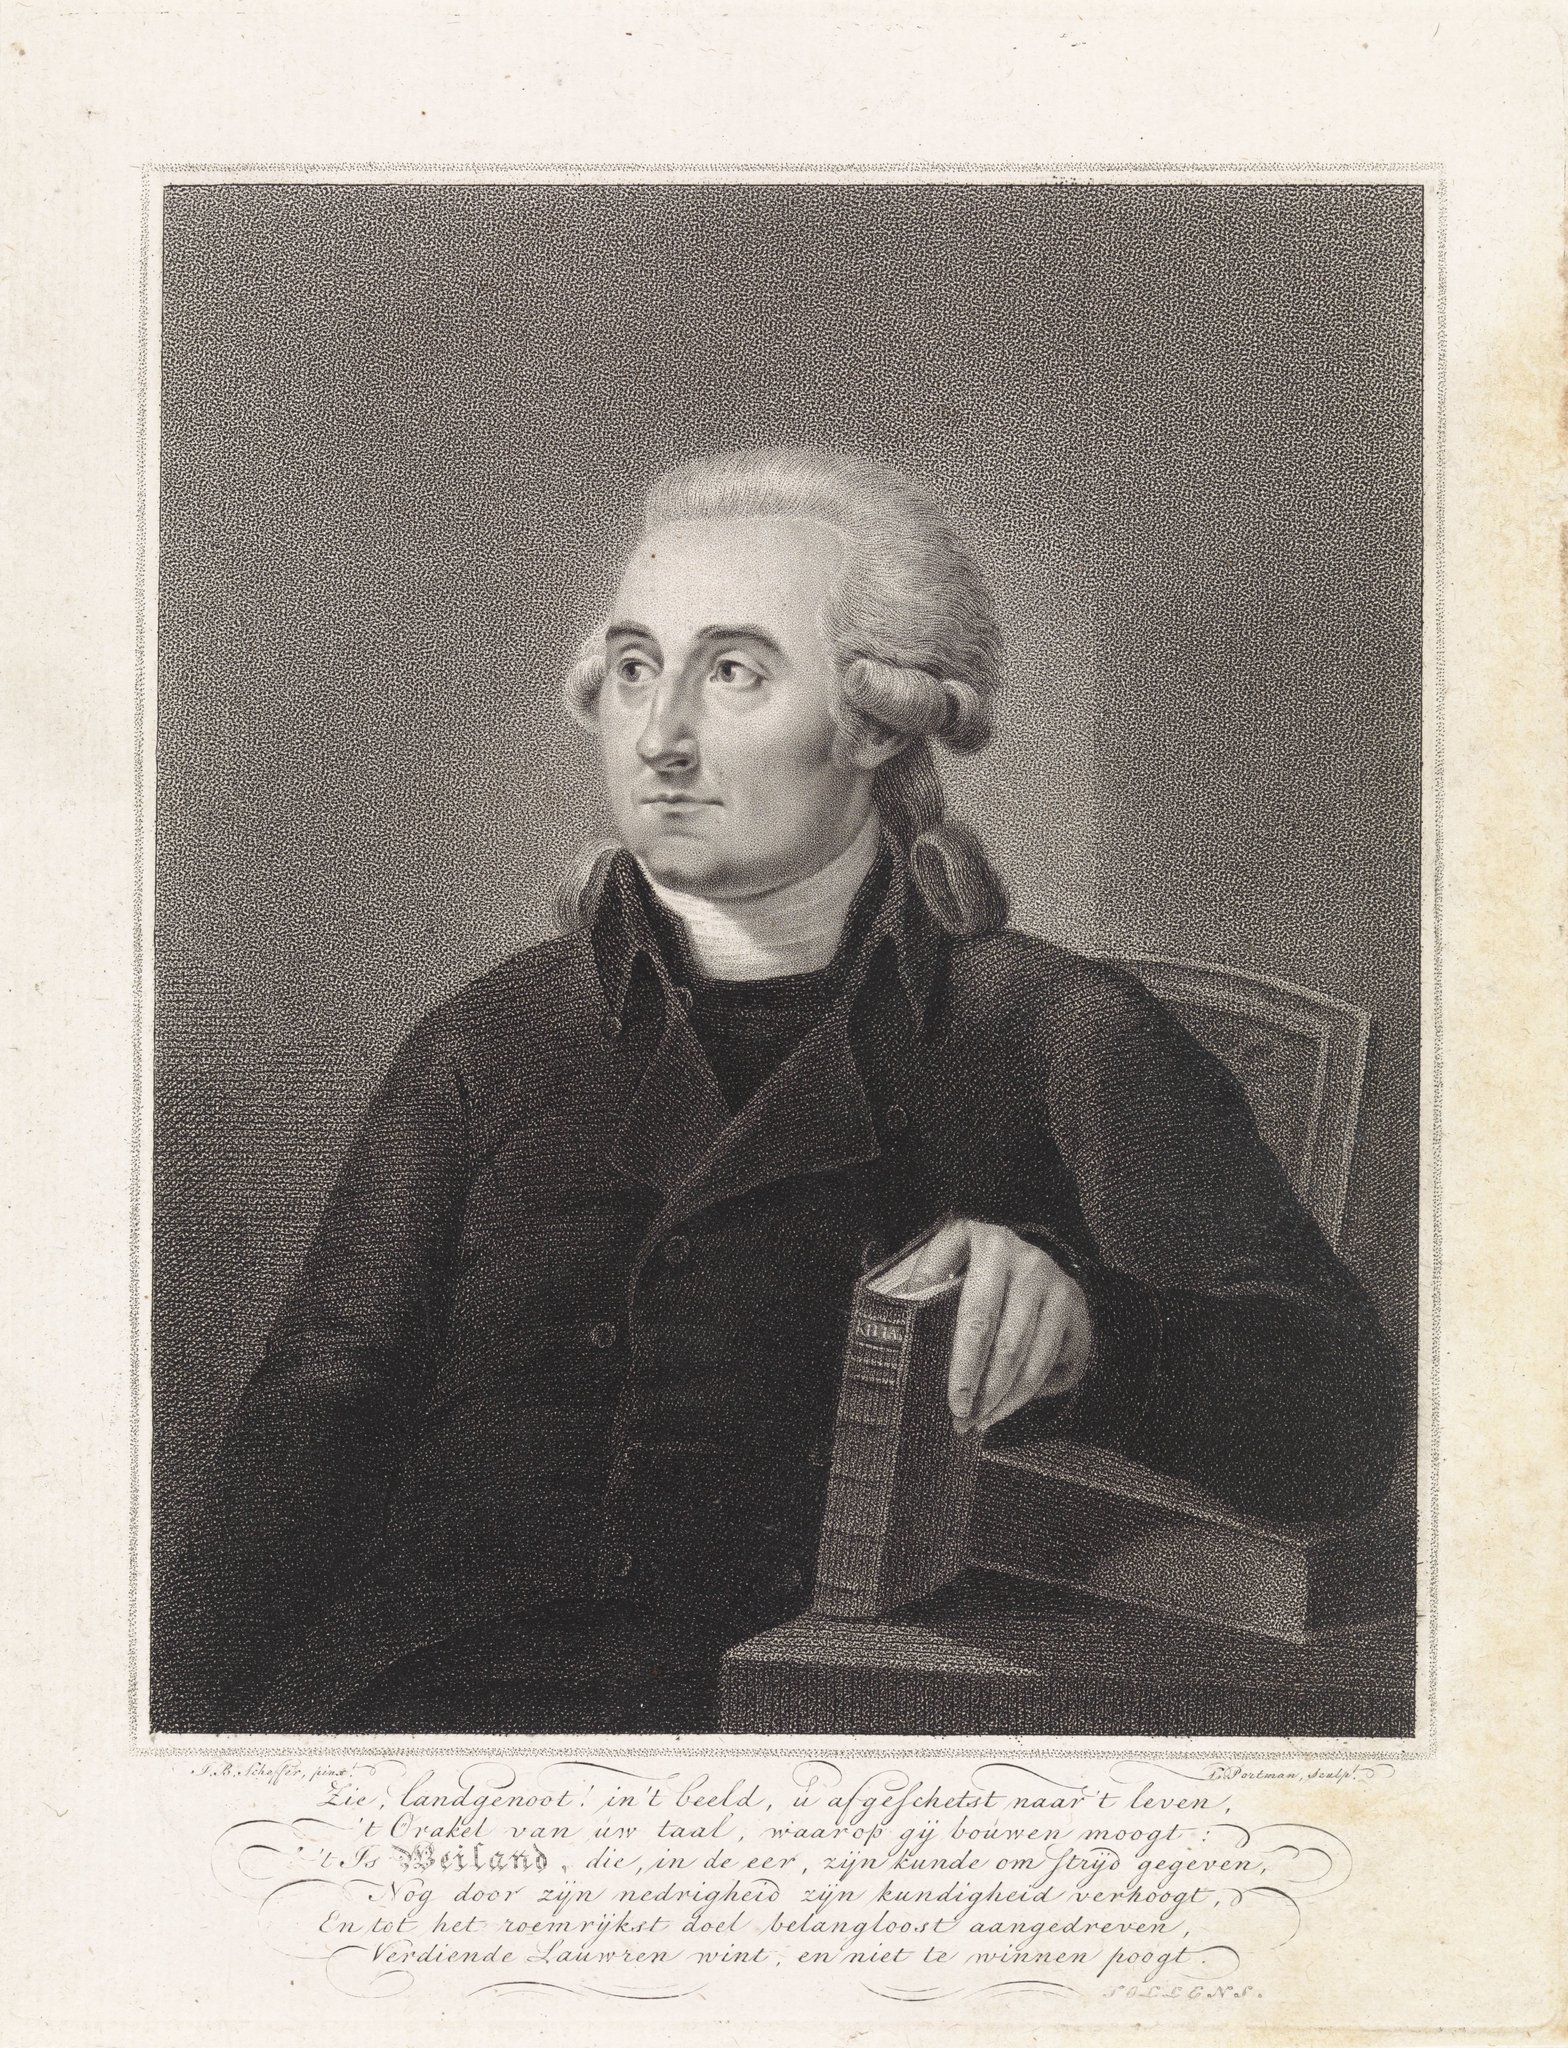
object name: print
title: Portret van Pieter Weiland, taalkundige en remonstrants predikant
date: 1787-1828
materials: paper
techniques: etching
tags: amsterdam, rotterdam, book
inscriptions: collector's mark: Lugt 2228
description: In zijn linkerhand houdt hij een boek van de schrijver Killian. In de marge een zesregelig lofdicht in het Nederlands.